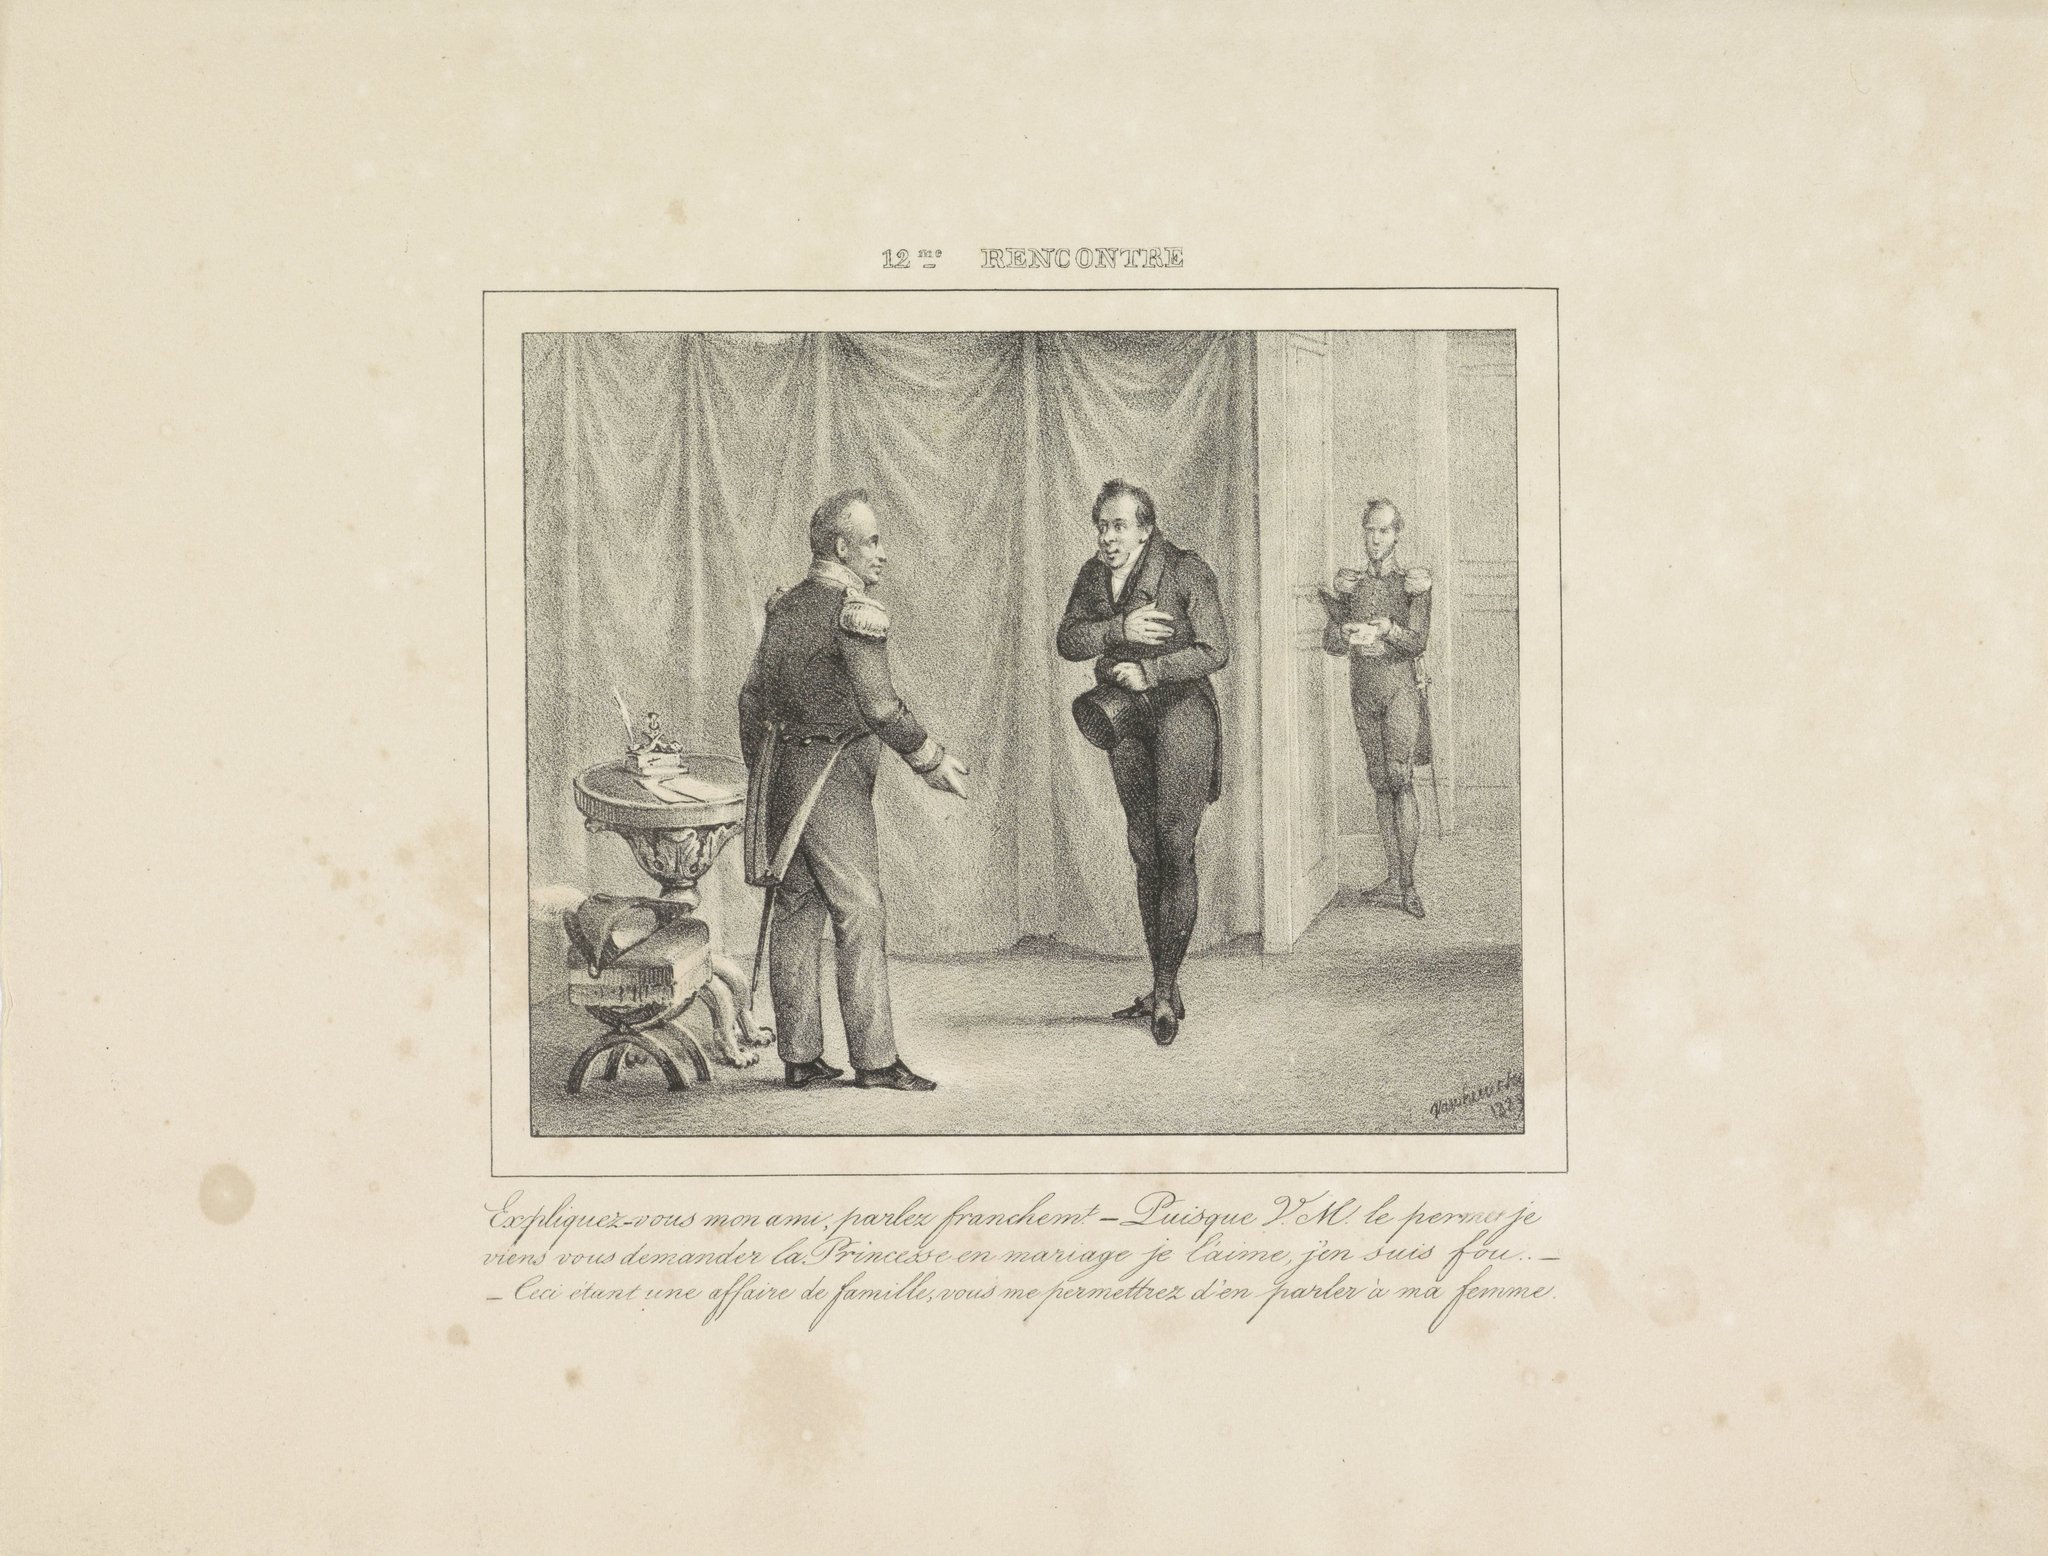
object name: print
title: 12me. rencontre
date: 1829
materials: paper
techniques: lithograph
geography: brussels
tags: the hague, berlin, william i of the netherlands, requesting the bride's parents' permission, ruler in informal contact with his subjects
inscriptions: collector's mark: Lugt 2228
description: De koning ontvangt een jongeman die hem om de hand van zijn dochter vraagt en antwoordt dat dit een familiezaak is die hij met zijn vrouw moet bespreken. Met drieregelig onderschrift. Onderdeel van de serie van 24 platen met ontmoetingen met koning Willem I, verschenen onder de titel 'Les rencontres' in 1829-1830.